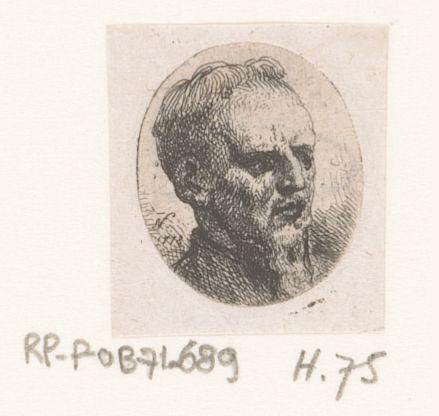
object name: print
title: Kop van man met sik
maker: jean pierre norblin de la gourdaine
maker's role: print maker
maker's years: 1745-1830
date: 1778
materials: paper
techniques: etching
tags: head (human), beard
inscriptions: date